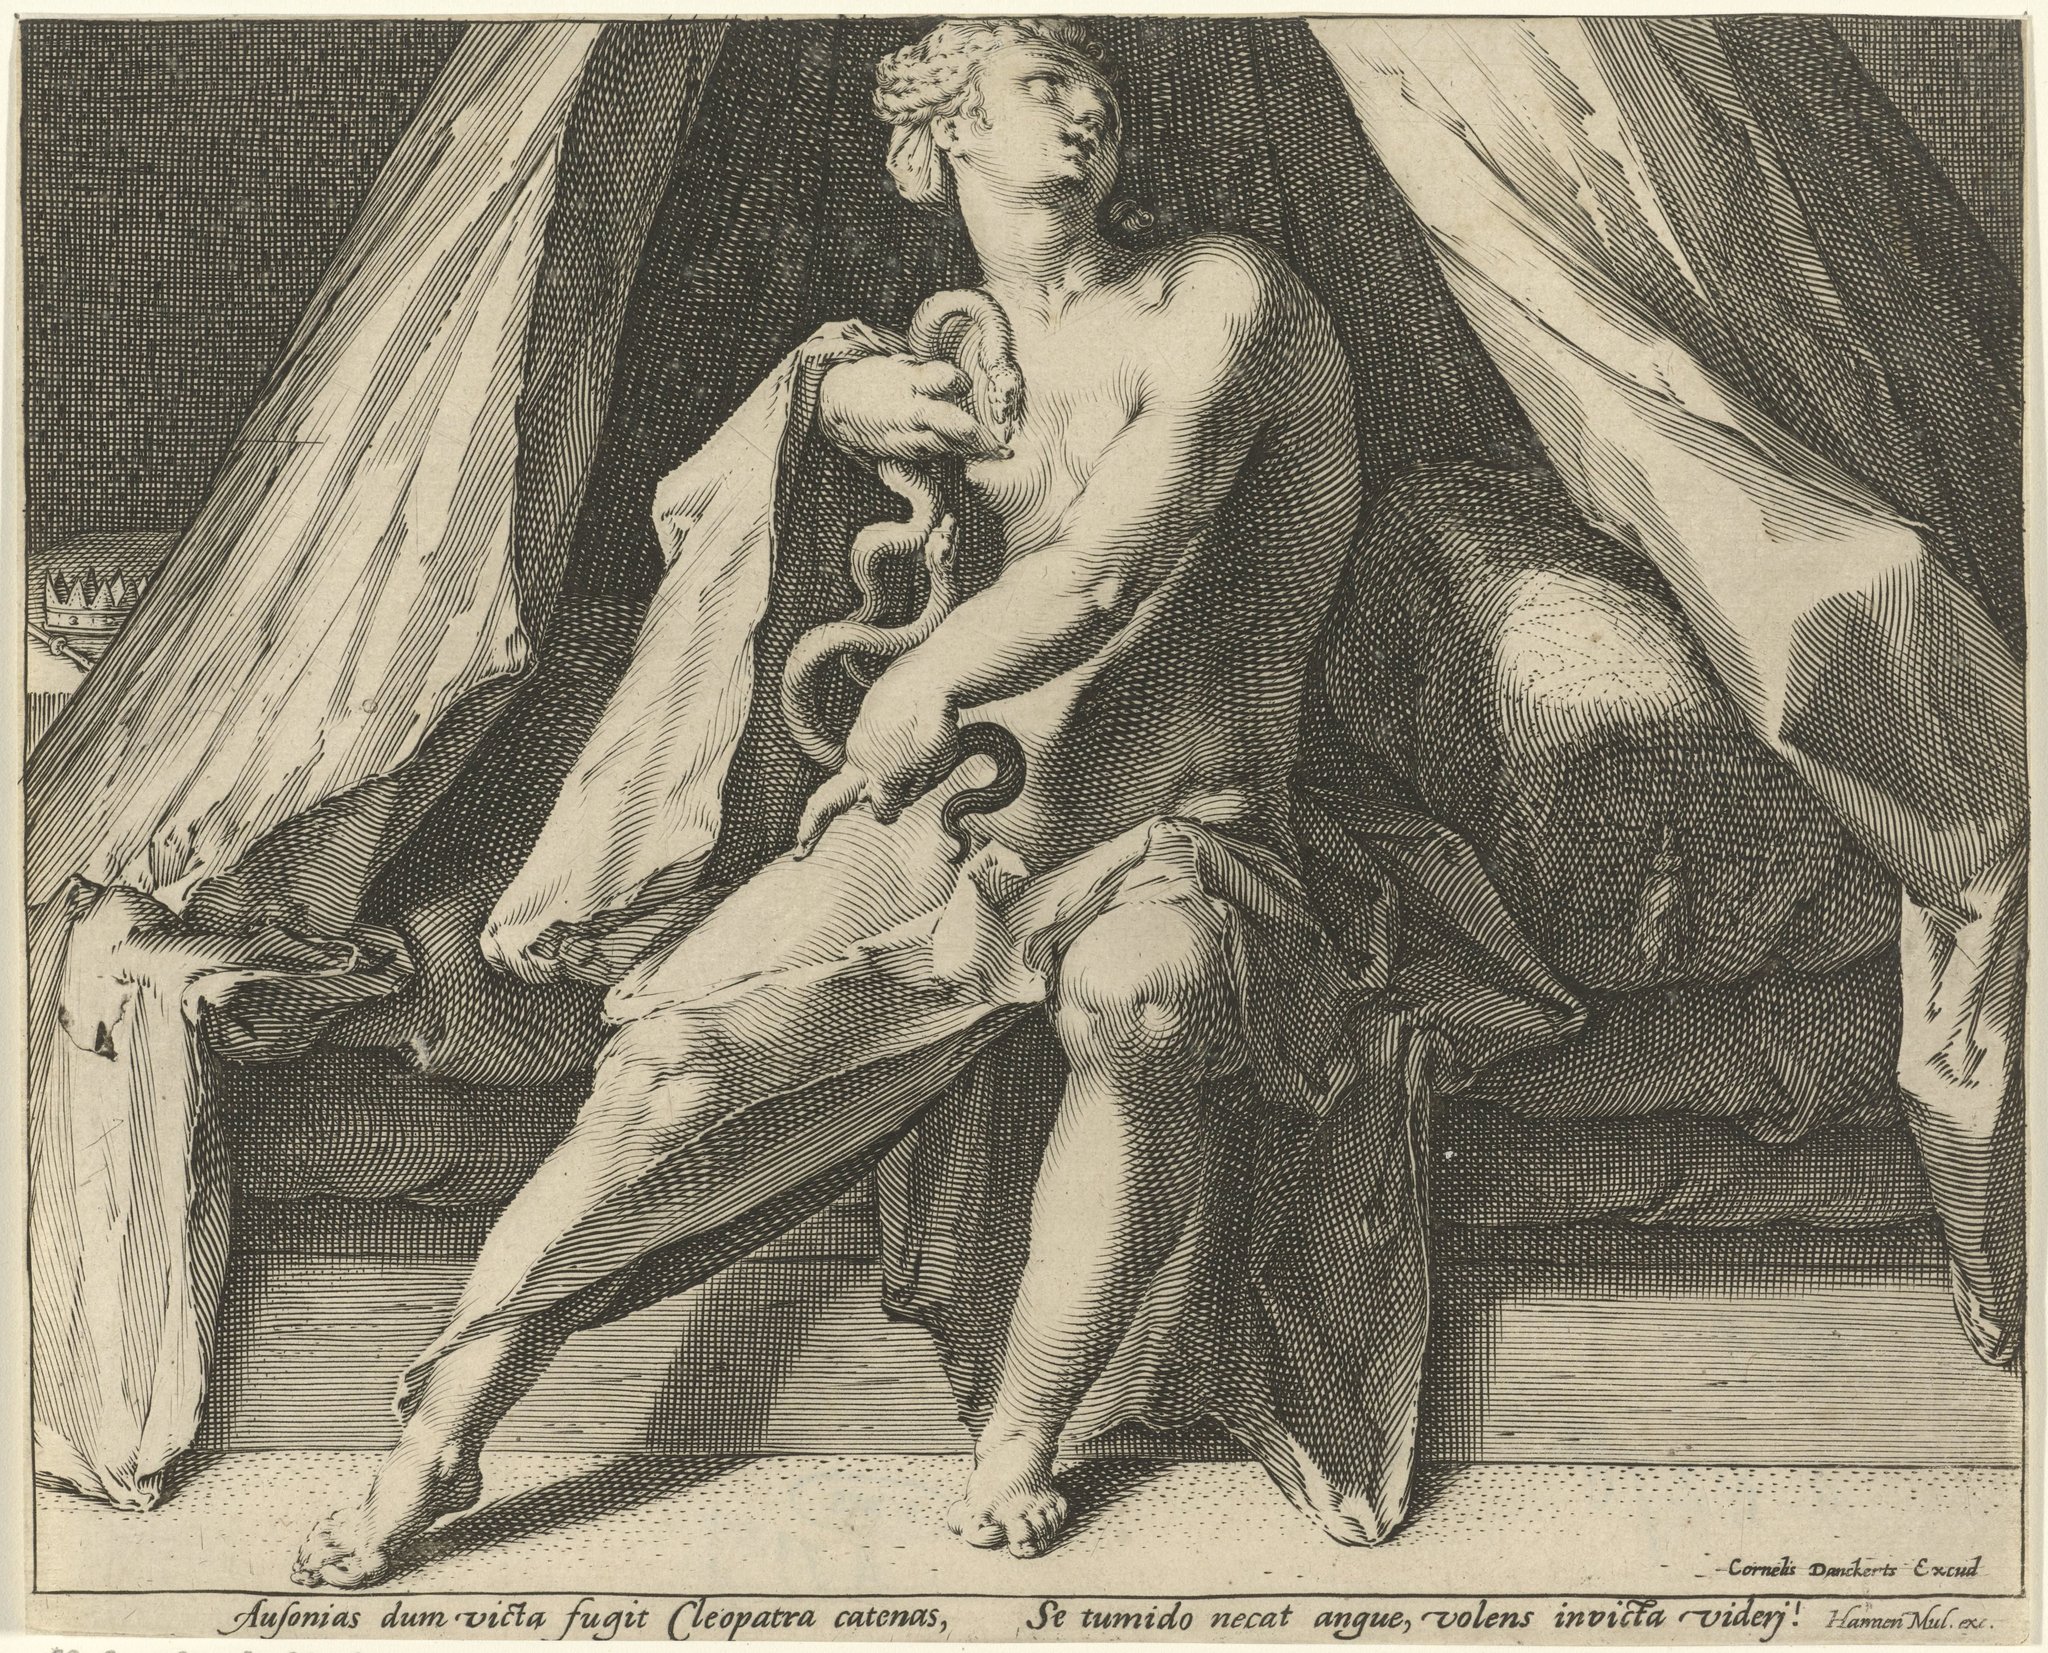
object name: print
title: Dood van Cleopatra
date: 1590-1594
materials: paper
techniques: engraving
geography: amsterdam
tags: death of cleopatra: she commits suicide by holding to her breast an asp, which she has taken from a basket of figs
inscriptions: collector's mark: Lugt 2228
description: Cleopatra pleegt zelfmoord door zich door een cobra te laten bijten. Ze zit naakt op haar bed. Rechts van het bed haar kroon en scepter.